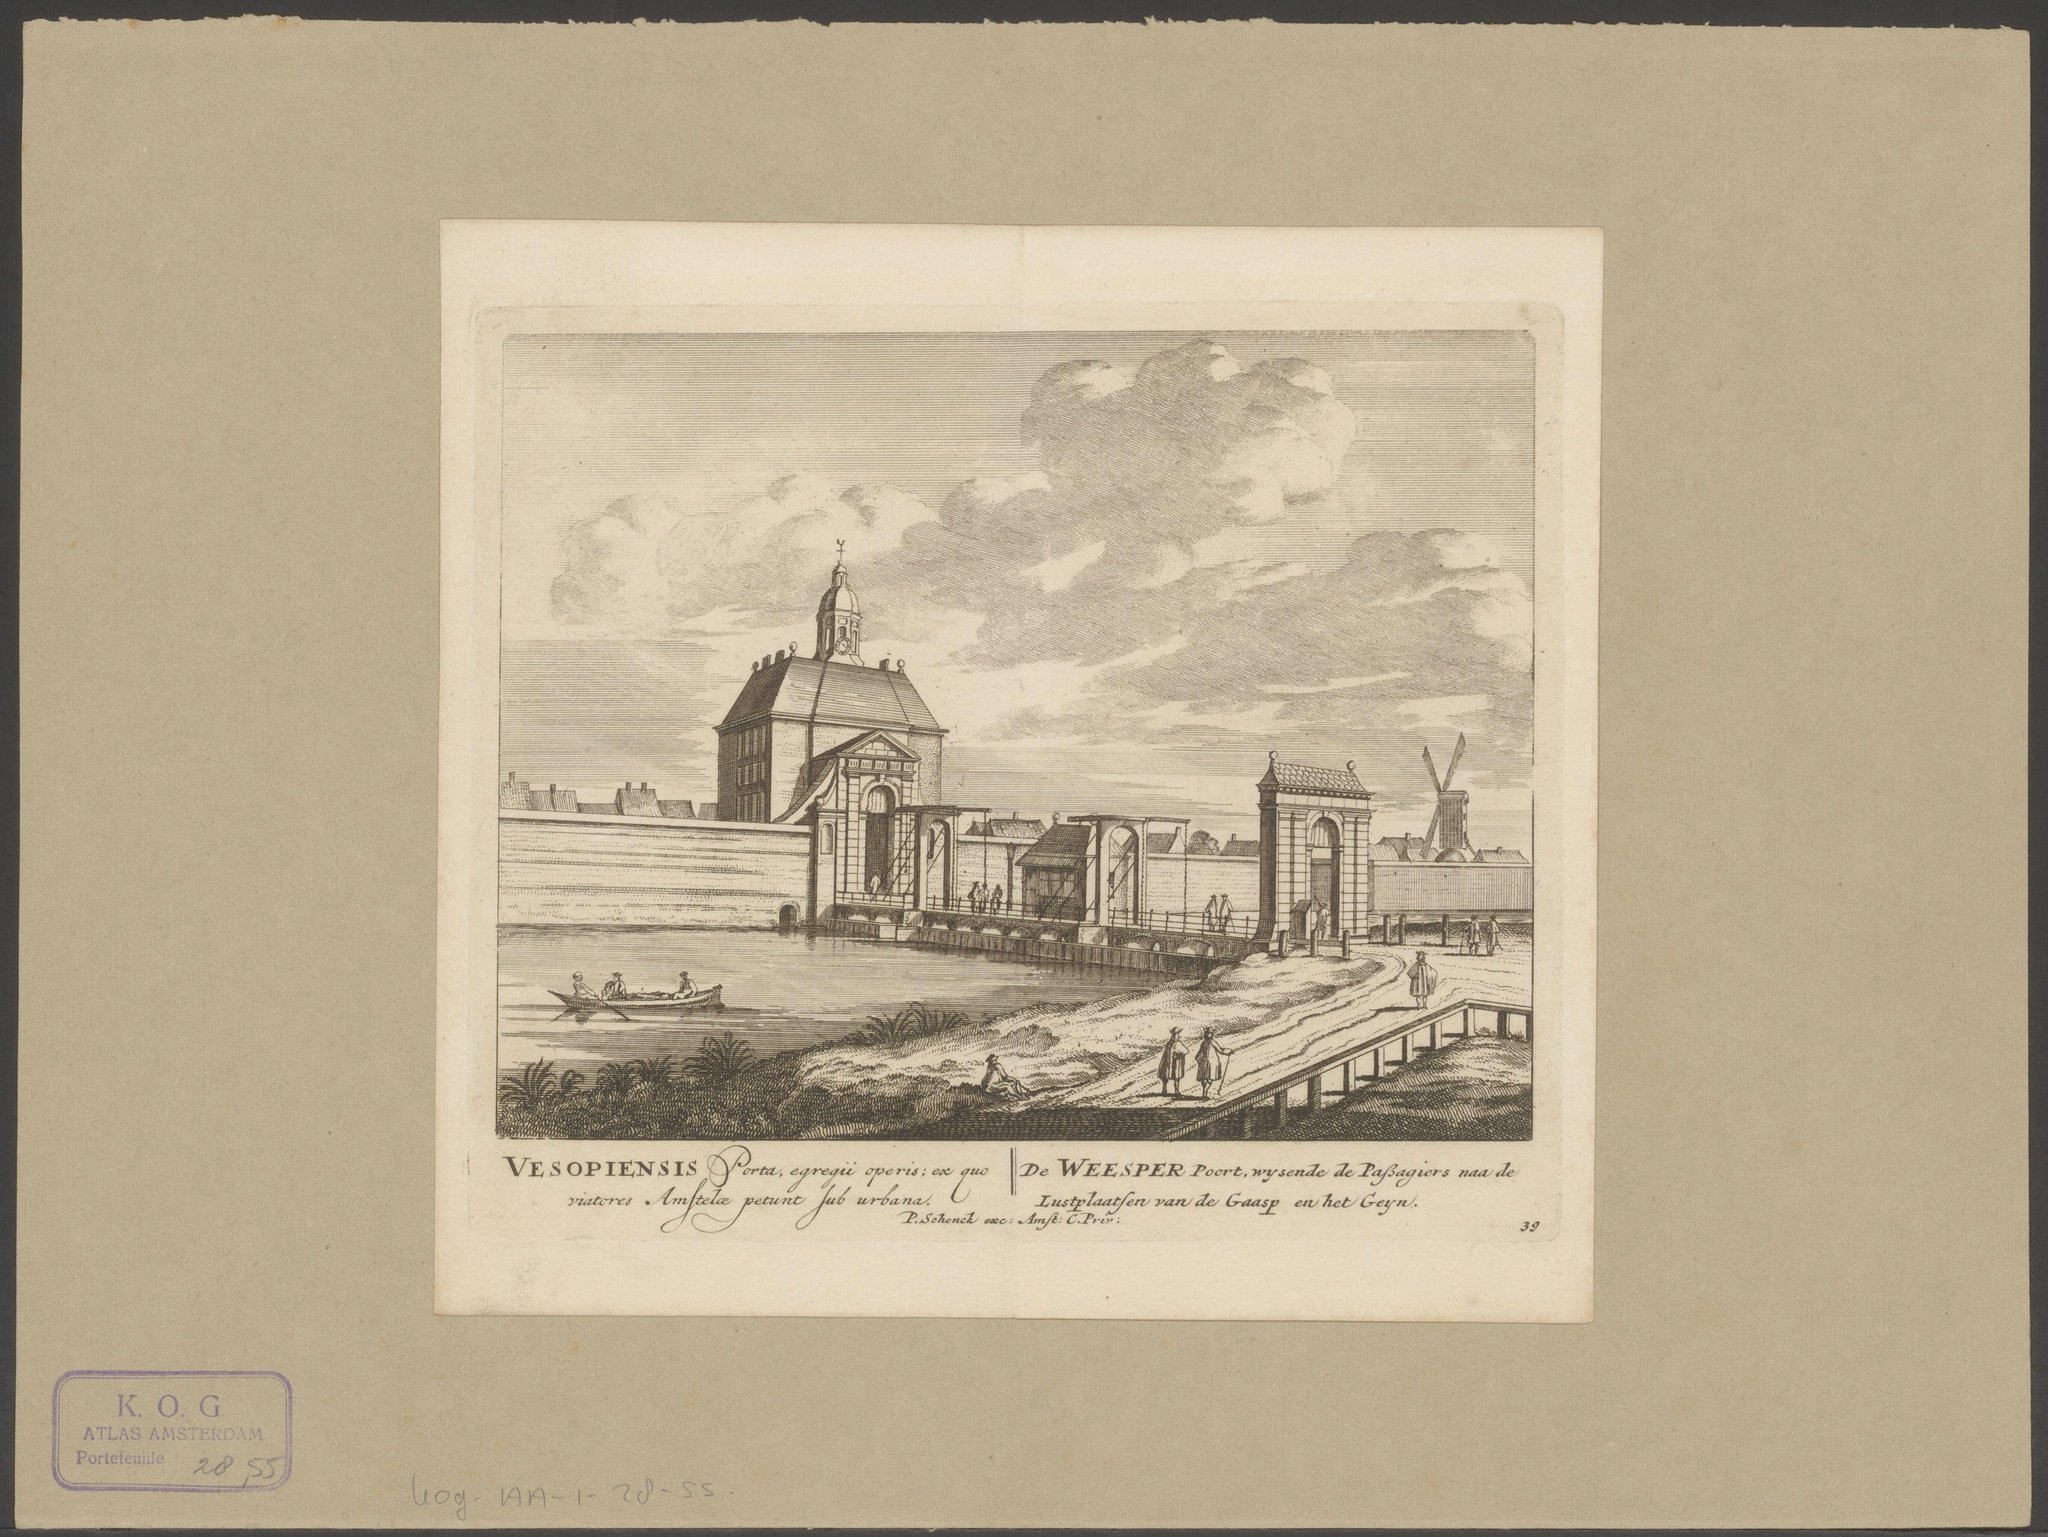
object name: print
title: 100 Afbeeldinge der voornaamste gebouwen van Amsterdam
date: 1710-1711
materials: paper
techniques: engraving, etching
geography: amsterdam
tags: windmill in landscape, city-gate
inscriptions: collector's mark: Lugt 1641b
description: Prent uit: 100 Afbeeldinge der voornaamste gebouwen van Amsterdam. Amsterdam, Pieter Schenk (I), [1710-1711]. Of: 100 Afbeeldinge der voornaamste gebouwen van Amsterdam. Amsterdam, Barent Greve, [1757-1766], prent nummer 40. In de tweede uitgave, uitgegeven door Barent Greve, is alleen de titelprent aangepast. De overige prenten zijn onveranderd gebleven.